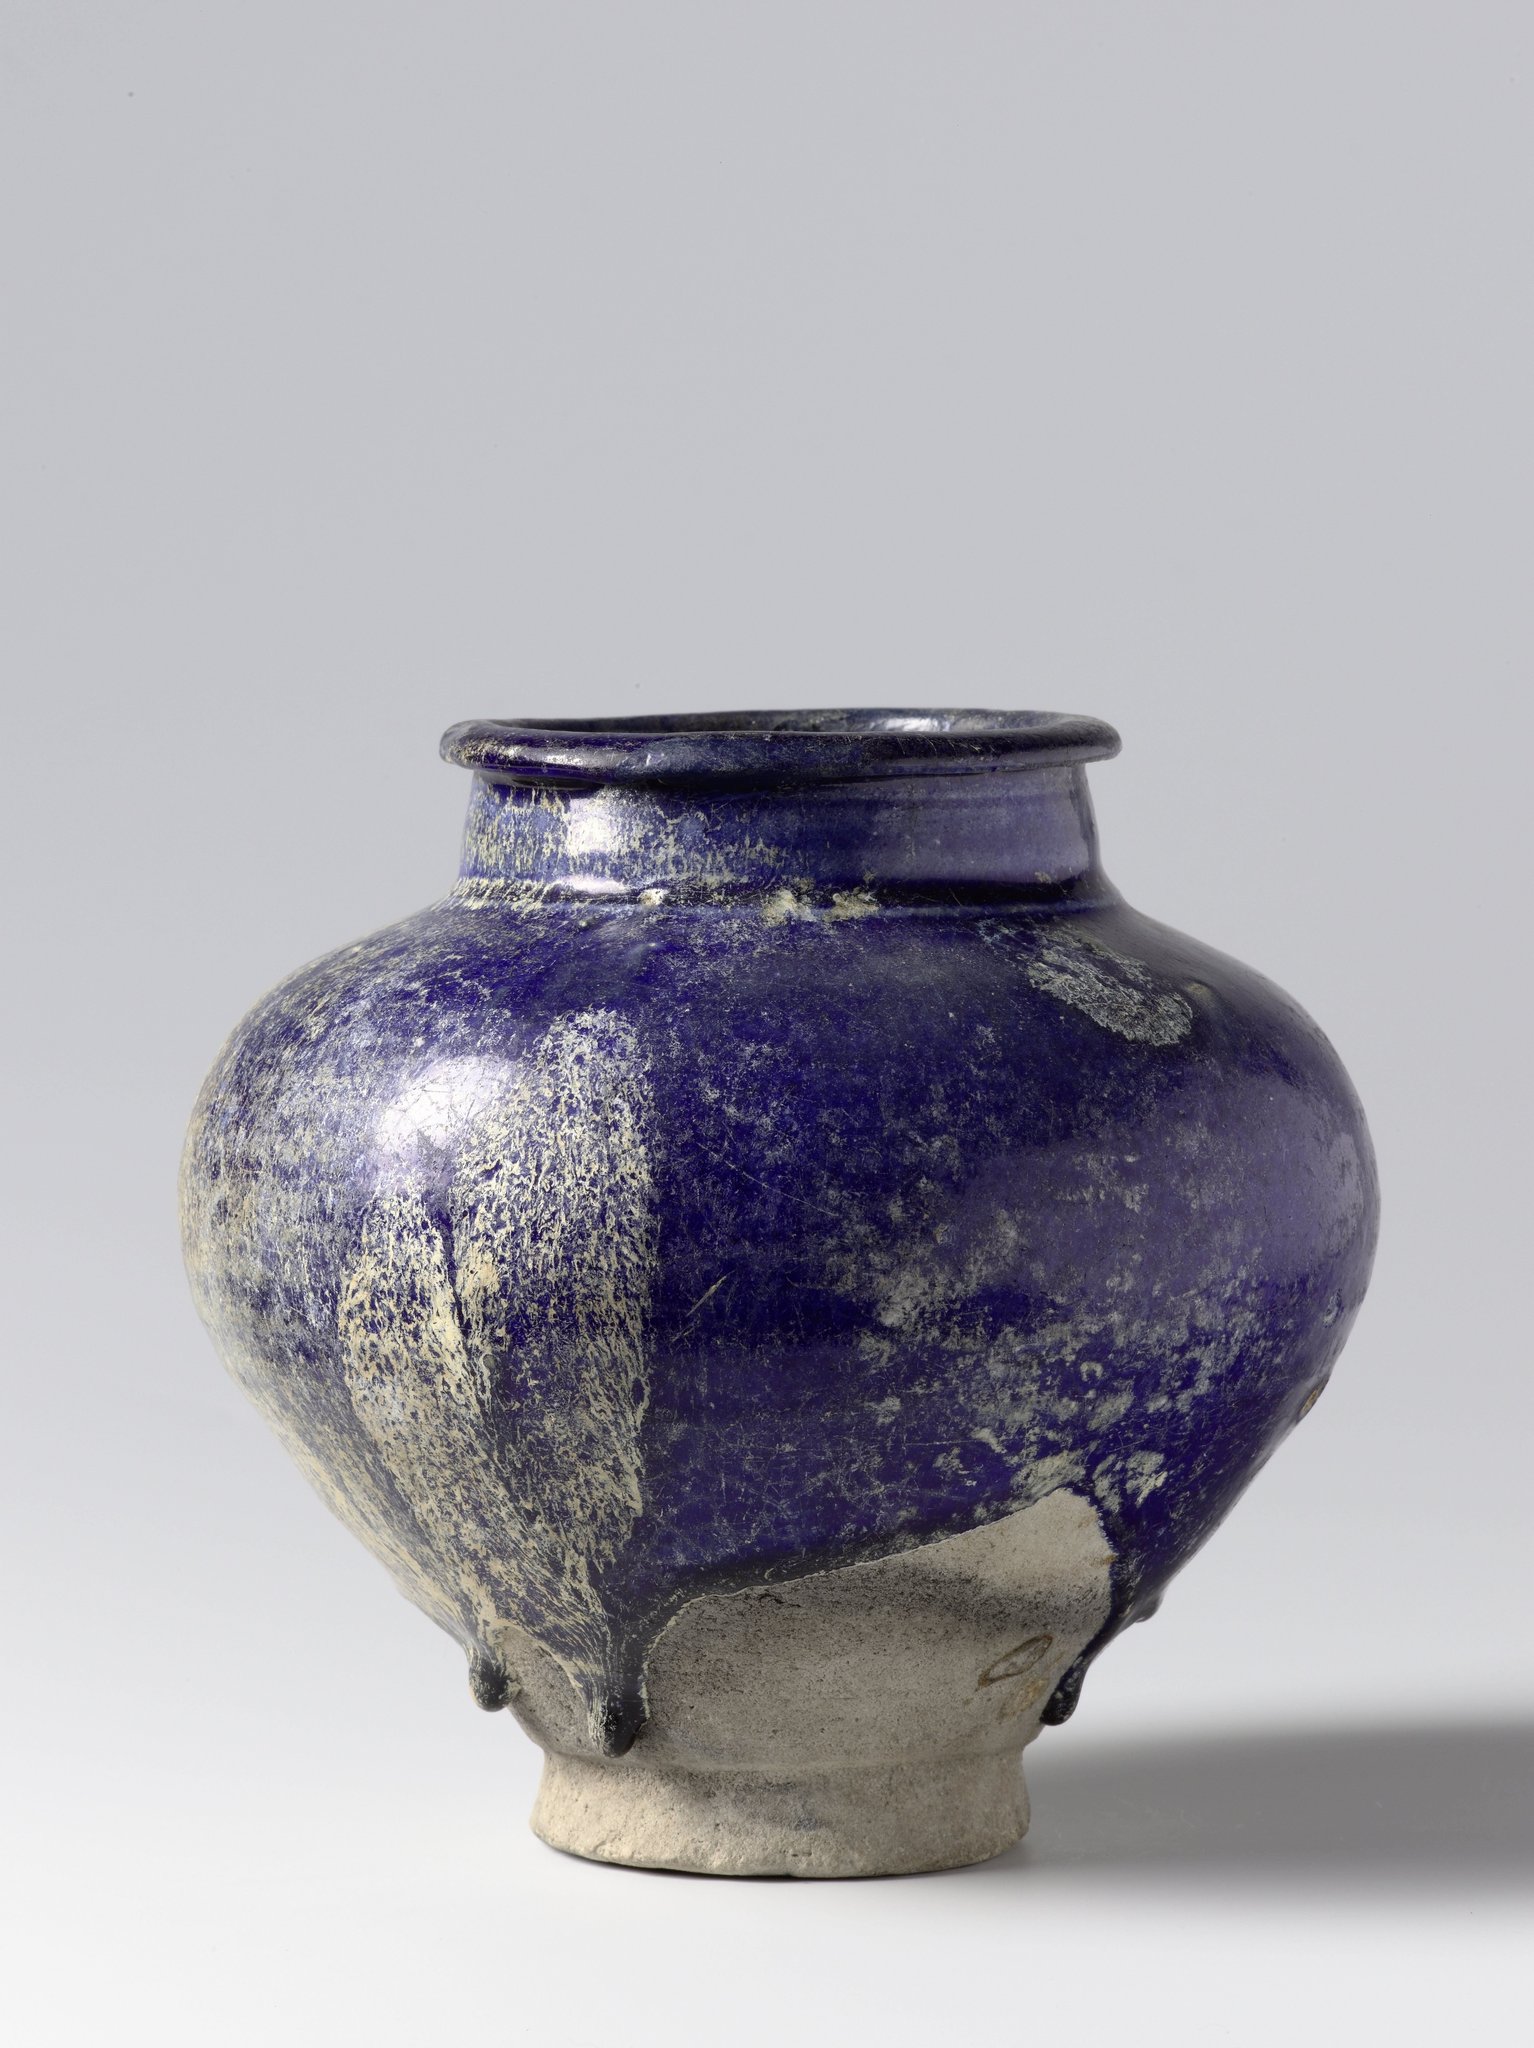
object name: pot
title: Ovoid jar with a blue glaze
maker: Anonymous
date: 1100-1299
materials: earthenware, glaze, quartz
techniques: firing, turning, vitrification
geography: iran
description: Pot van kwarts-fritgoed grotendeels bedekt met een monochroom blauw alkaliglazuur.